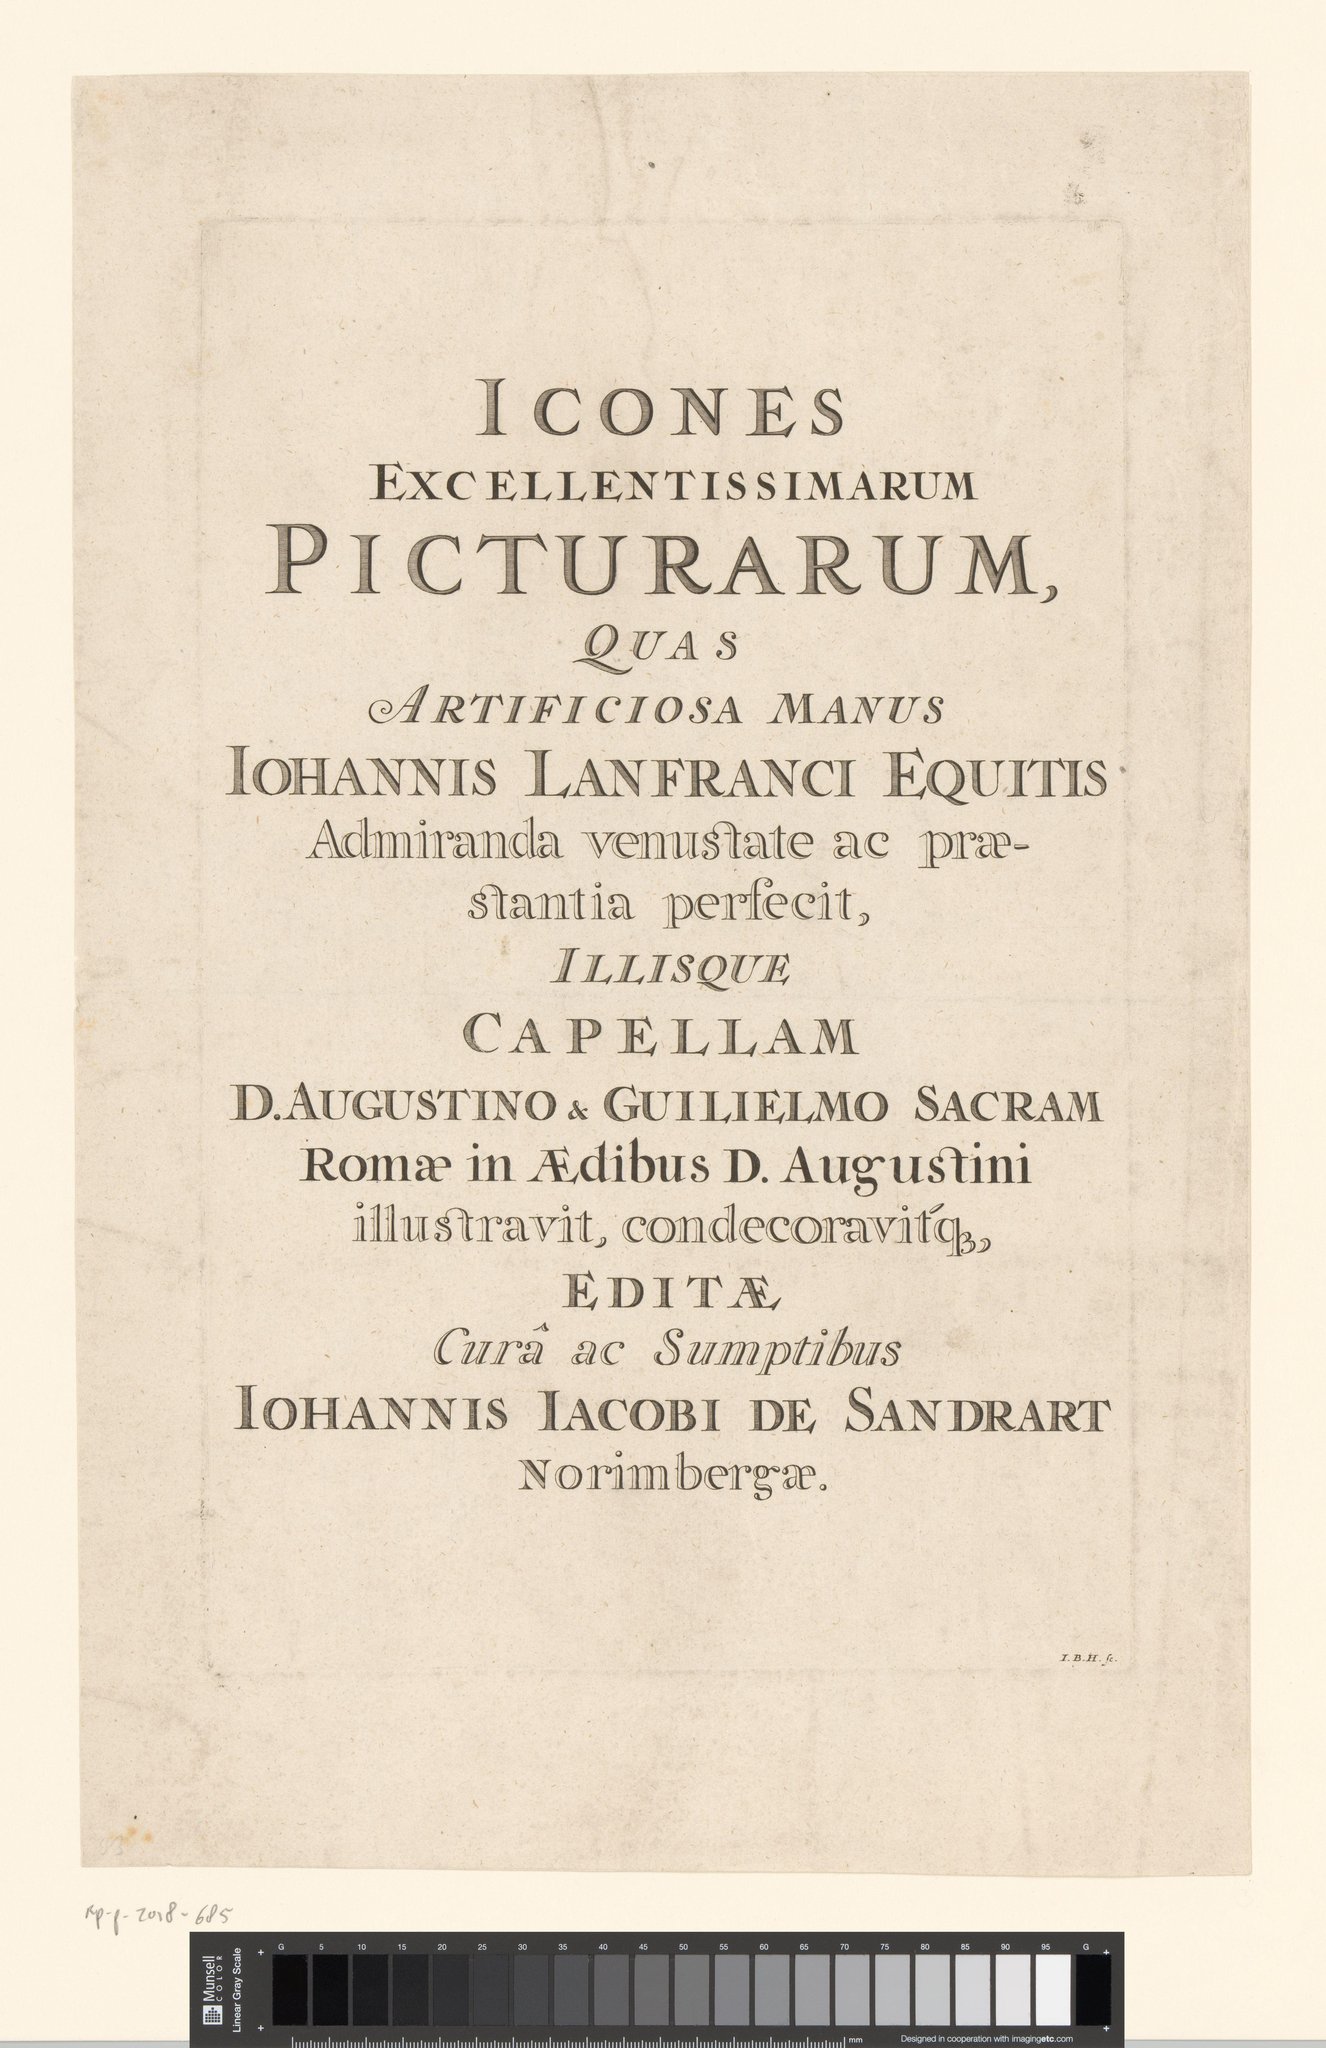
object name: print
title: Icones Excellentissimarum Picturarum (...)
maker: monogrammist ibh (17e-18e eeuw)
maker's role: print maker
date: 1678-1691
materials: paper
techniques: engraving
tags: sant'agostino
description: Titelprent voor een serie van 9 prenten.